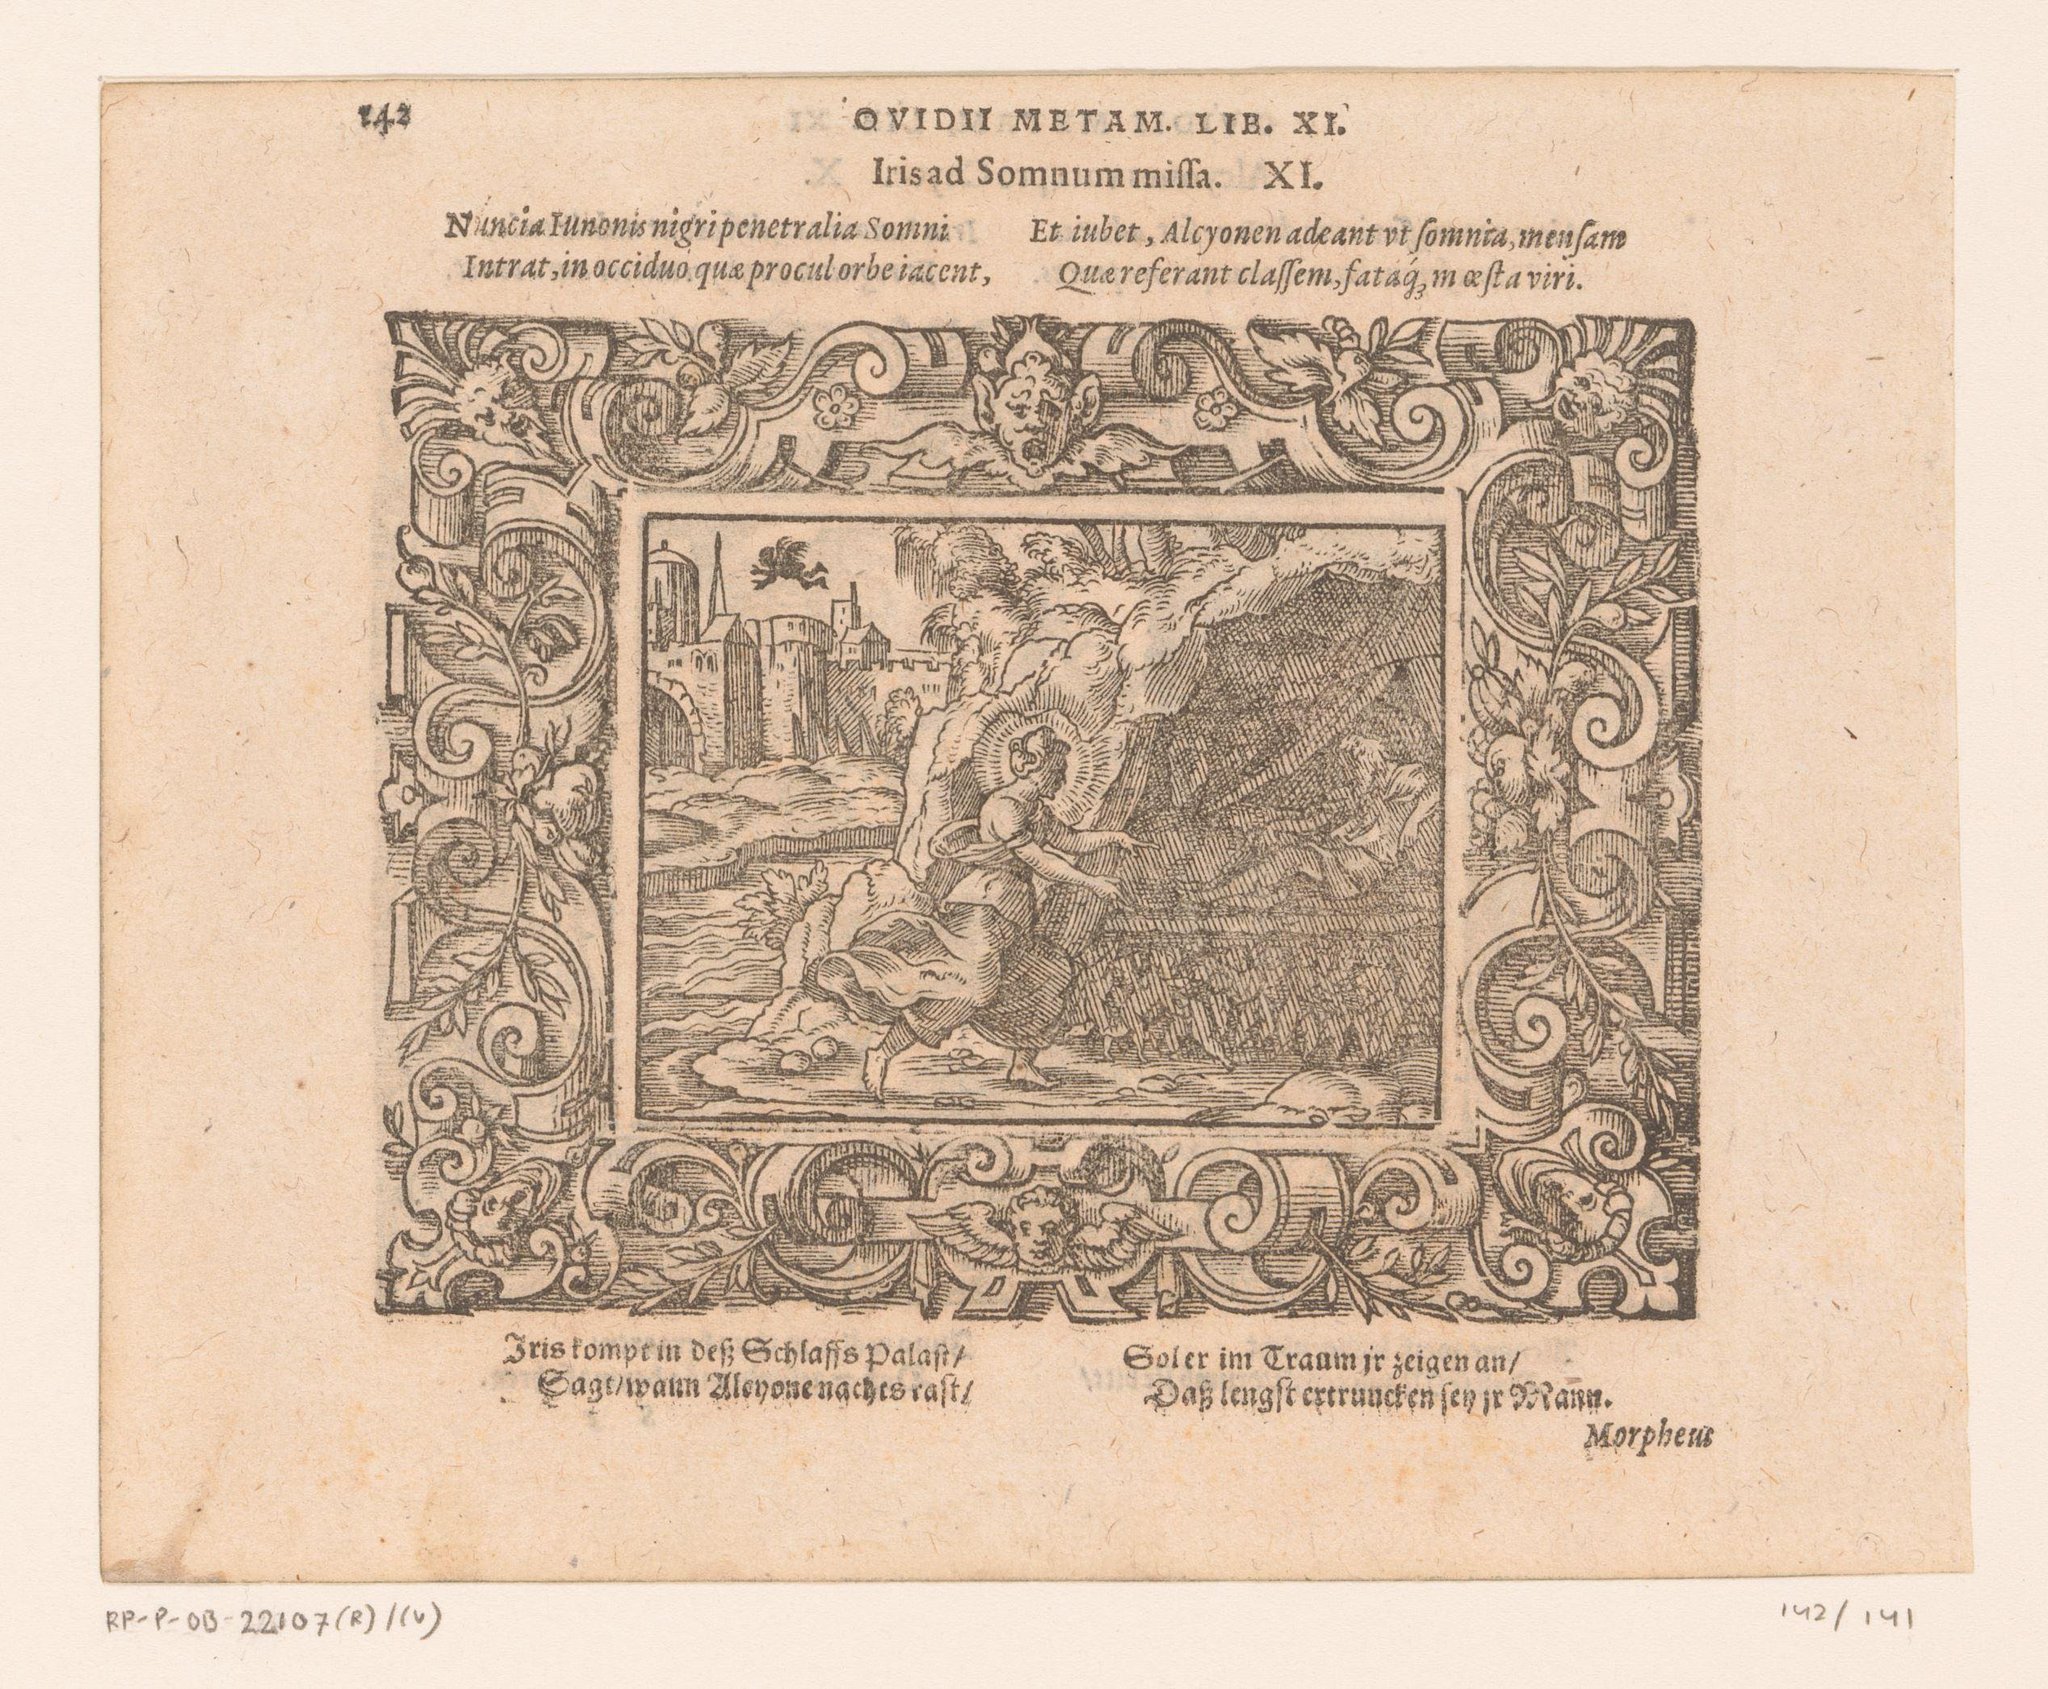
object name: print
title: Iris ad Somnum missa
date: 1569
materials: paper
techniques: letterpress printing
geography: frankfurt am main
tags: iris visits hypnos on alcyone's behalf, scrollwork, strapwork ~ ornament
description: Illustratie bij de Metamorfosen van Ovidius, afkomstig uit de publicatie: Posthius, Johannes. Tetrasticha in Ovidii metam. Frankfurt am Main: Georg Rab en Sigmund Feyerabend en erven Weigand Han, 1569. De voorstellingen en ornamentranden van deze boekillustraties zijn van twee aparte blokken gedrukt. Beide werden afzonderlijk van elkaar ook gebruikt voor andere publicaties, en de ornamentranden werden eveneens binnen deze publicatie meerdere keren gebruikt.